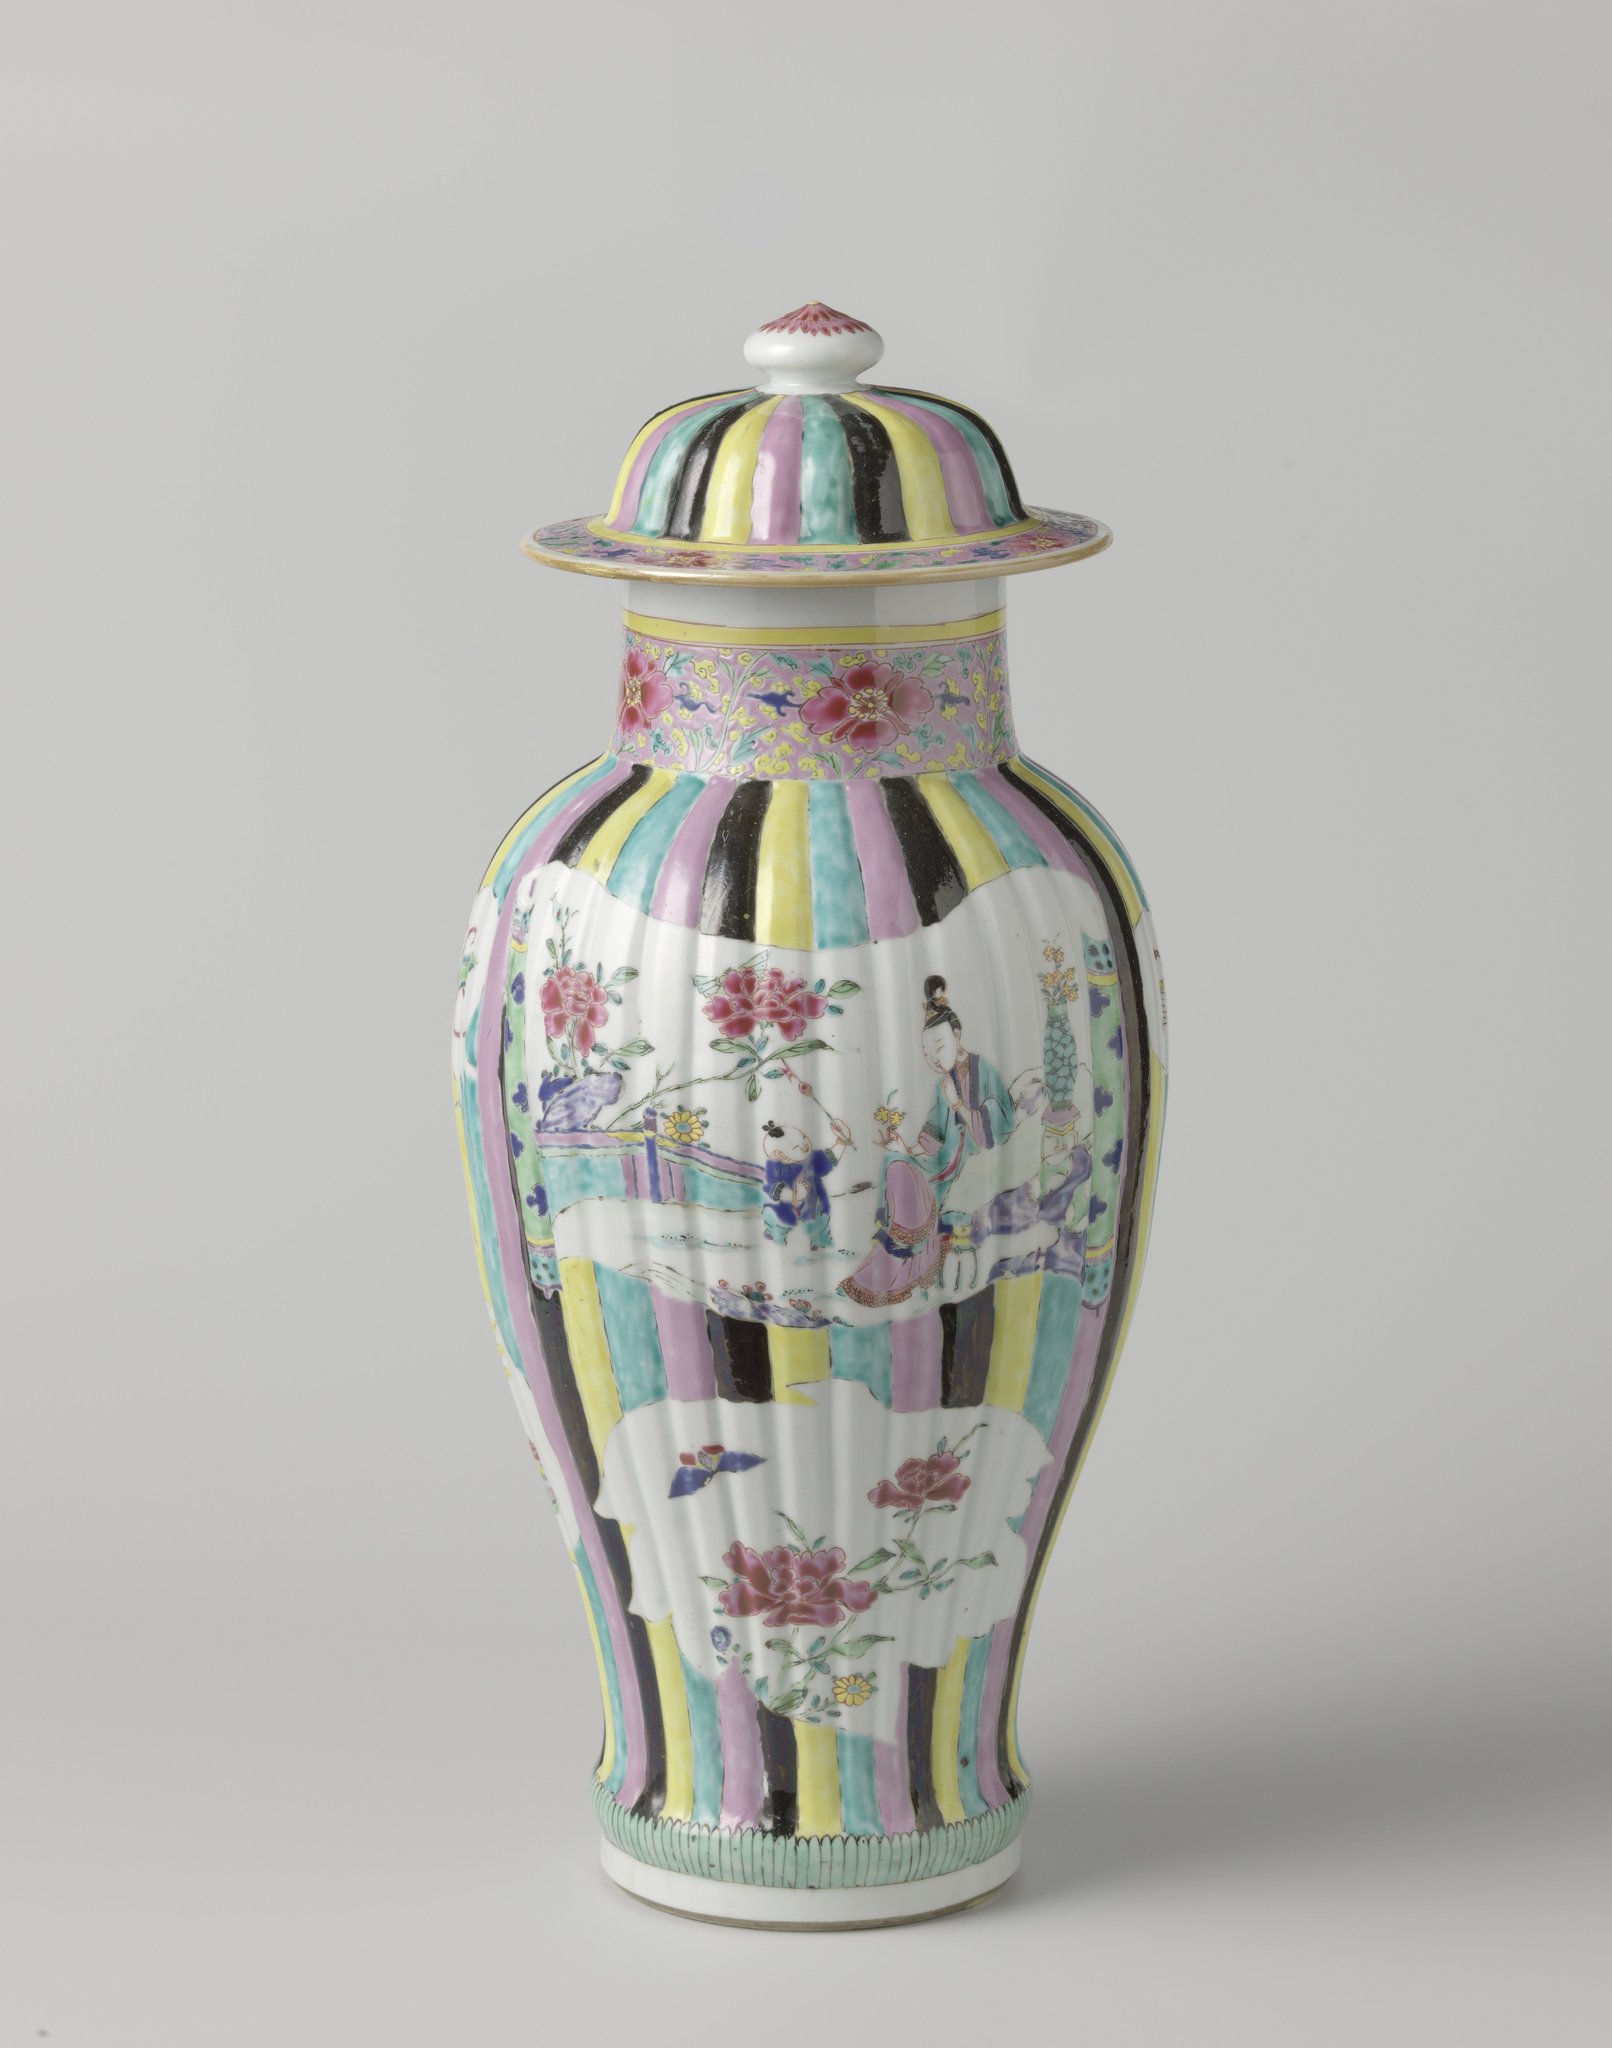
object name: pot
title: Covered jar with figures, flower sprays and auspicious symbols in shaped panels on a multi-colored ground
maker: Anonymous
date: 1725-1740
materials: glaze, gold, paint, porcelain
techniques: firing, forming, gilding, turning, vitrification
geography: china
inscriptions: label: ‘17100/ 91 [...]003/ 5’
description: Dekselpot met harlequin motief behorend bij vijfdelig kaststel.